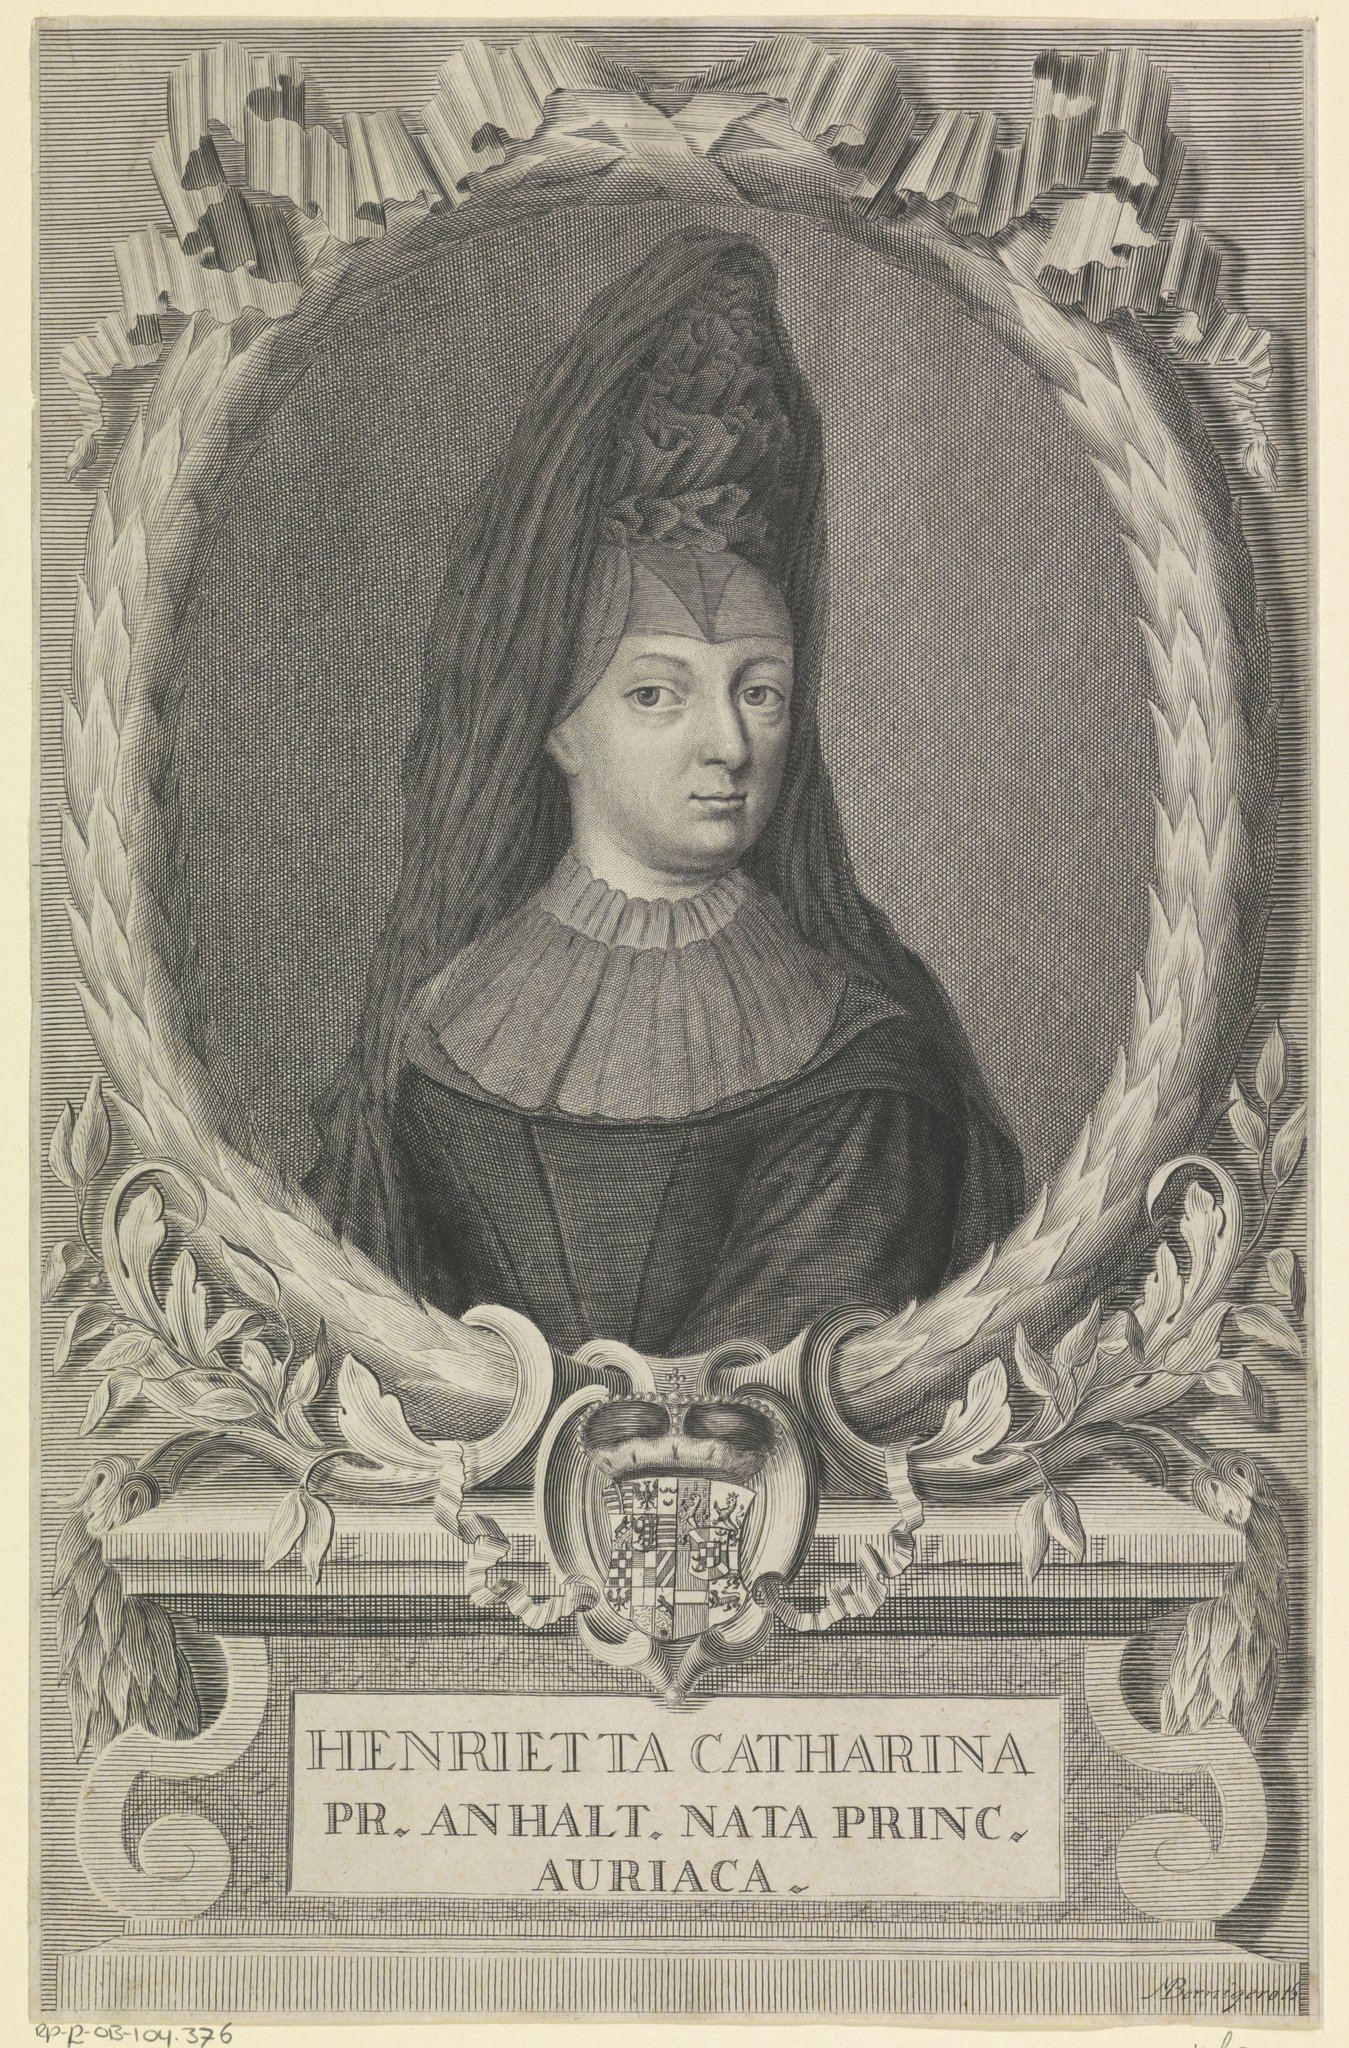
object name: print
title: Portret van Henriëtte Catharina, prinses van Oranje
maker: johann martin bernigeroth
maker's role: print maker, publisher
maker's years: 1713-1767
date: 1713-1767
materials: paper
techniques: engraving, etching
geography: leipzig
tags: the hague, henriëtte catharina (prinses van oranje)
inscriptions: collector's mark: Lugt 963, collector's mark: Lugt 2228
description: De hier vermelde titel verwijst naar de hoogst verkregen titel van de geportretteerde, niet per se naar de titel die de geportretteerde op deze voorstelling draagt.